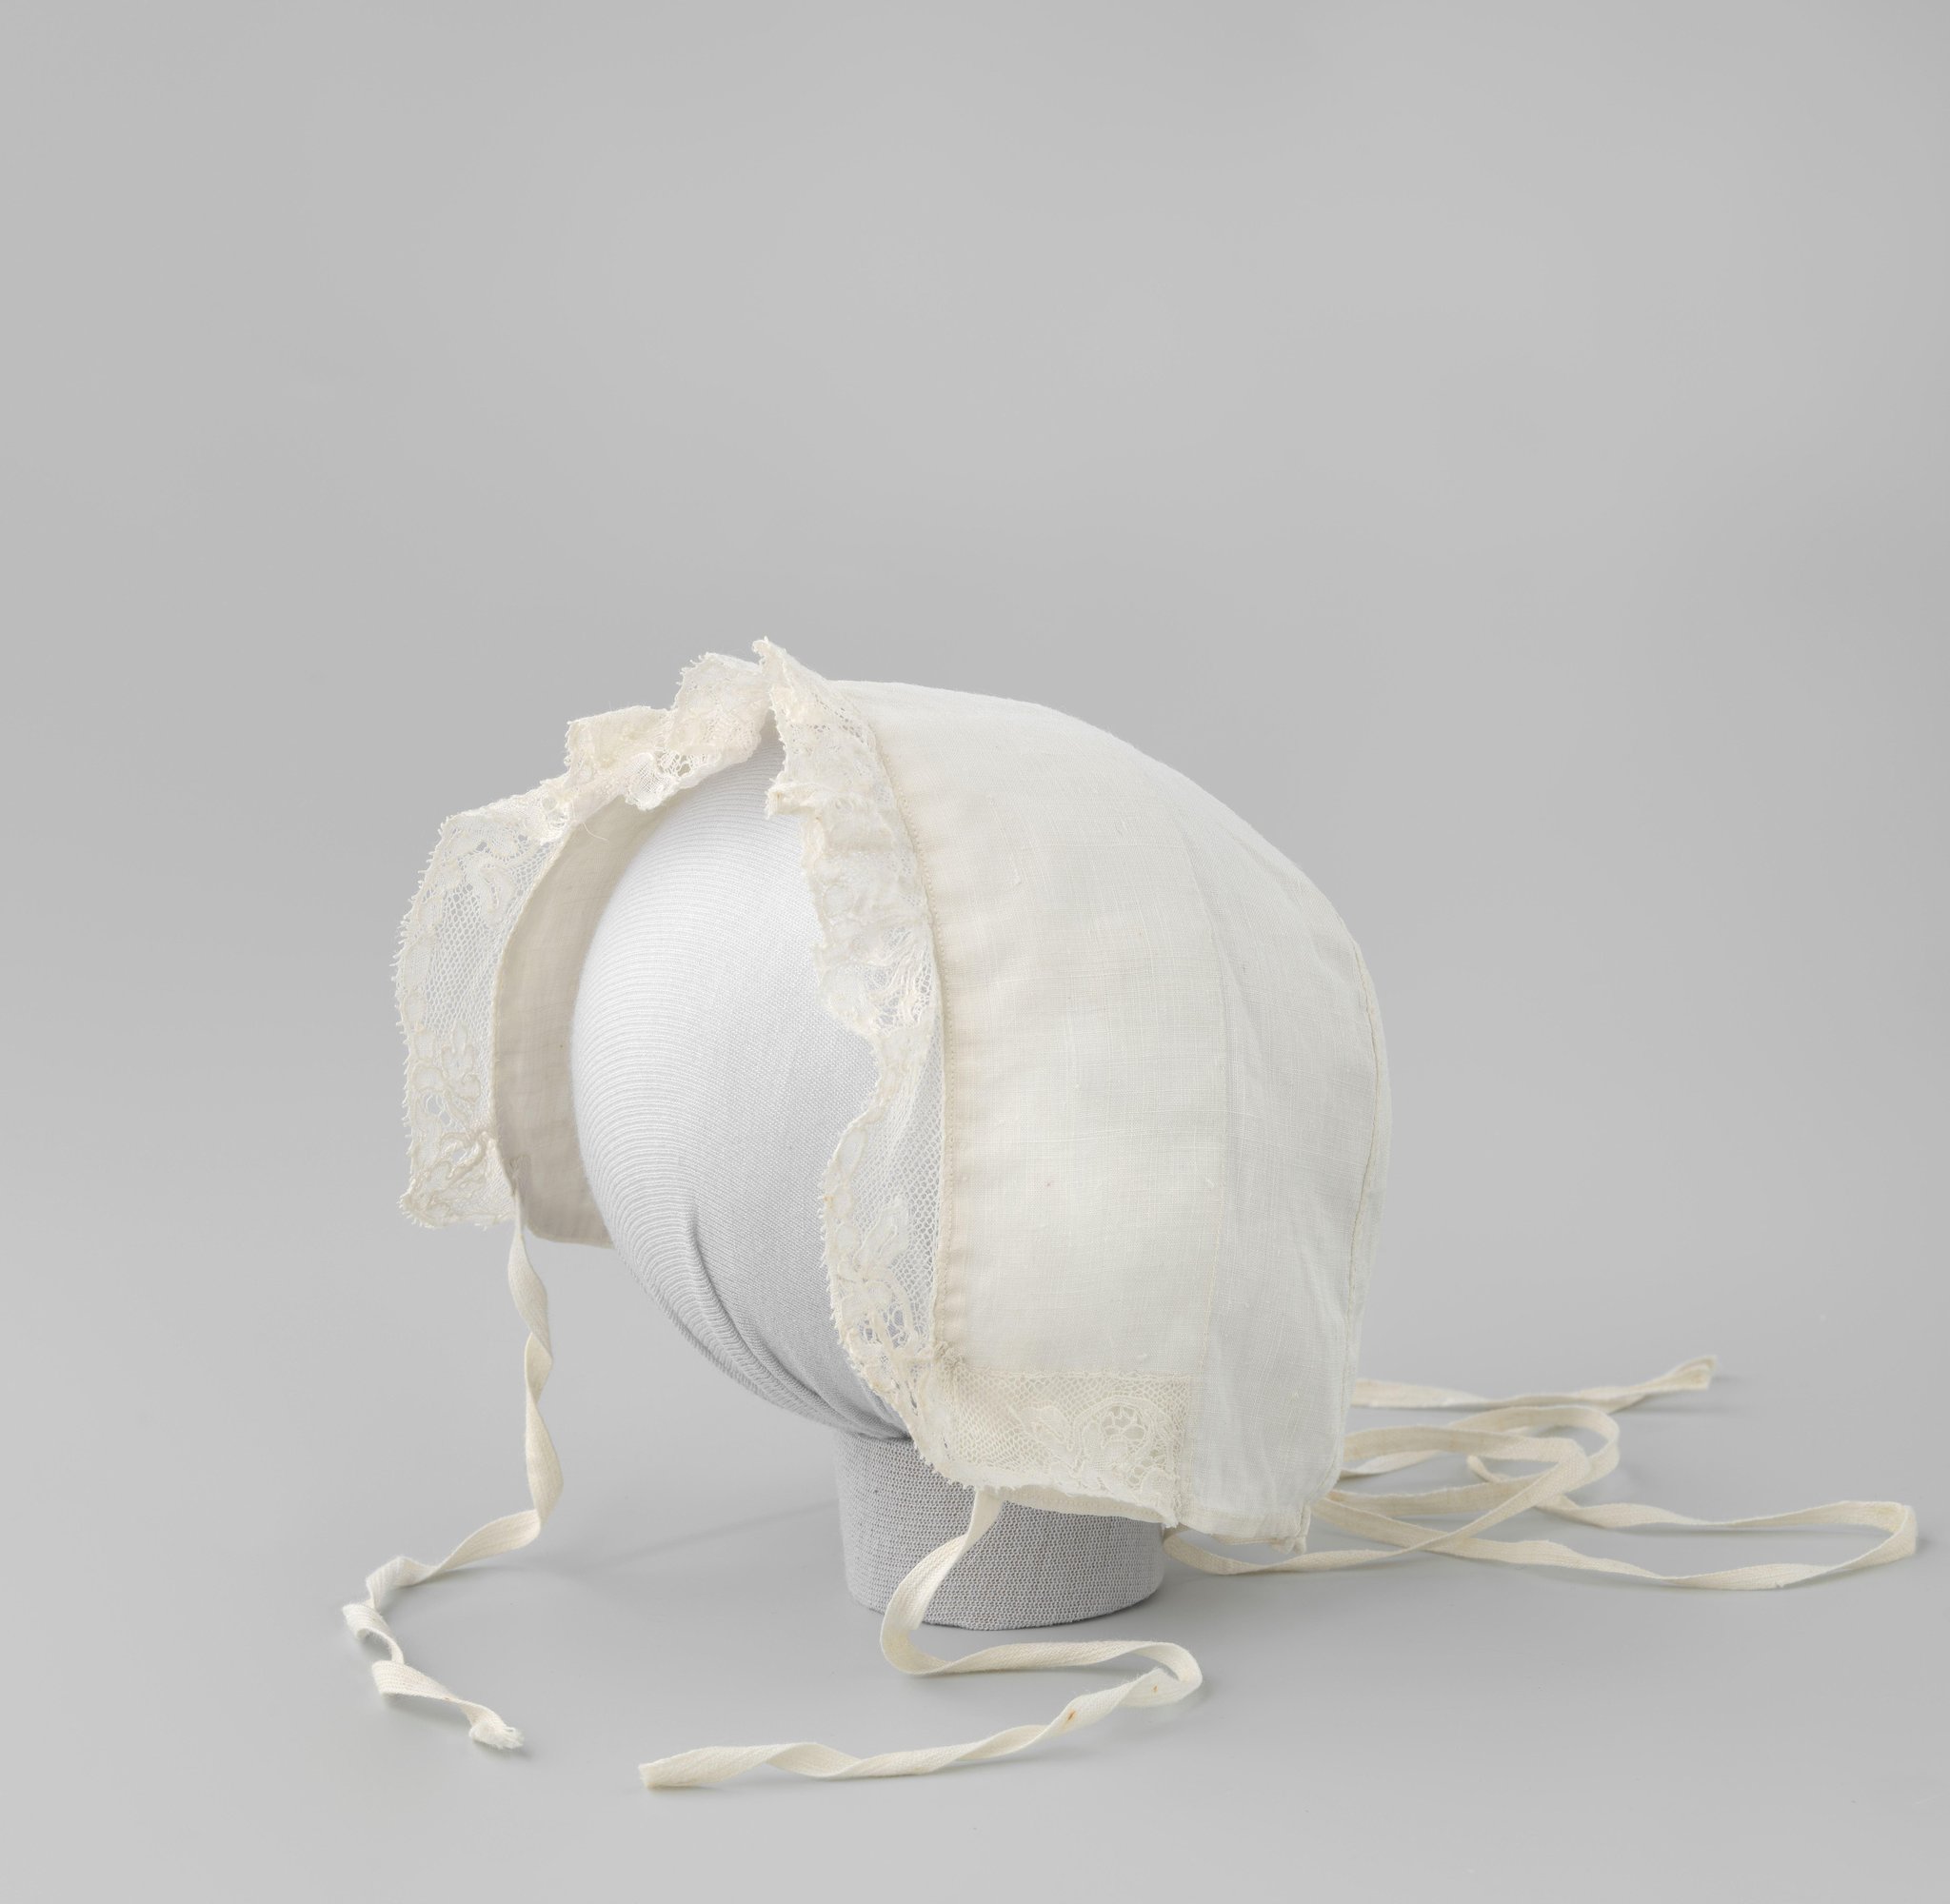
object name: babymuts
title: Witte babymuts met linten en strook kant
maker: Anonymous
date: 1800-1900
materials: textile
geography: europe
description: Witte babymuts met vier linten en strook kant.